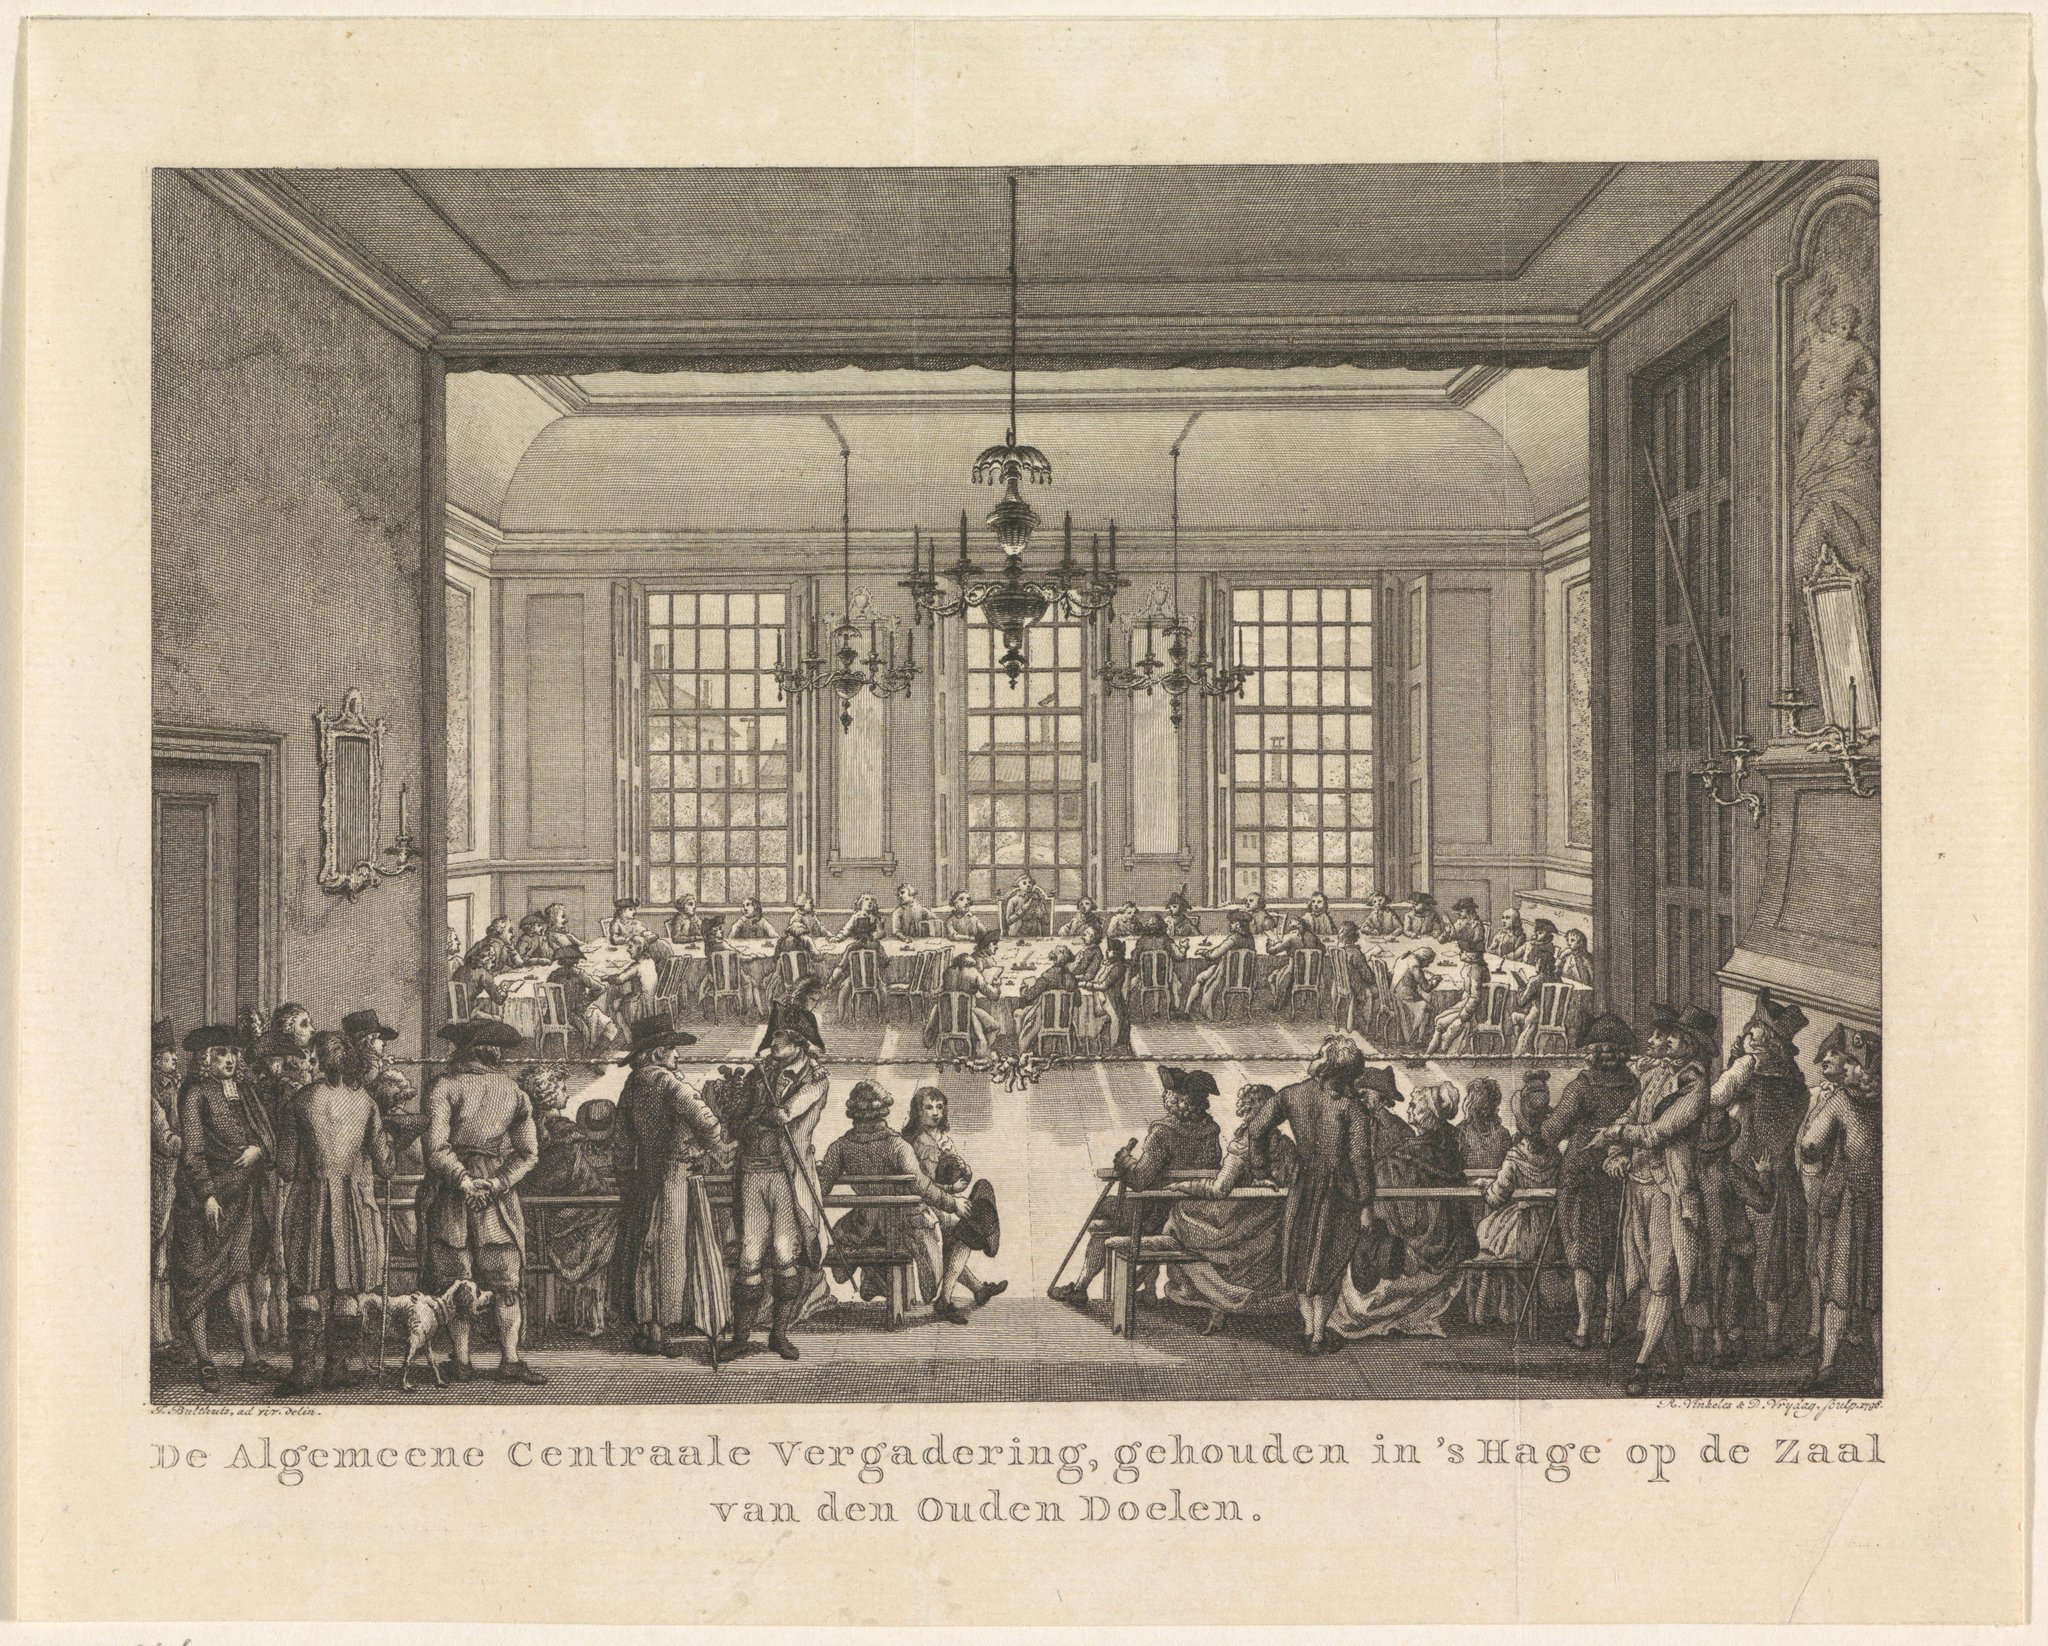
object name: print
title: De Algemeene Centraale Vergadering, gehouden in 's Hage op de Zaal van den Ouden Doelen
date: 1796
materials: paper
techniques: engraving, etching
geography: amsterdam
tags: national government, politics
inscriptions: collector's mark: Lugt 2228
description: Huidige staat van prent ook gebruikt in: Rogge, Cornelis. Tafereel van de geschiedenis der jongste omwenteling in de Vereenigde Nederlanden. Amsterdam: Johannes Allart, 1796, tussen p. 578 en 579.